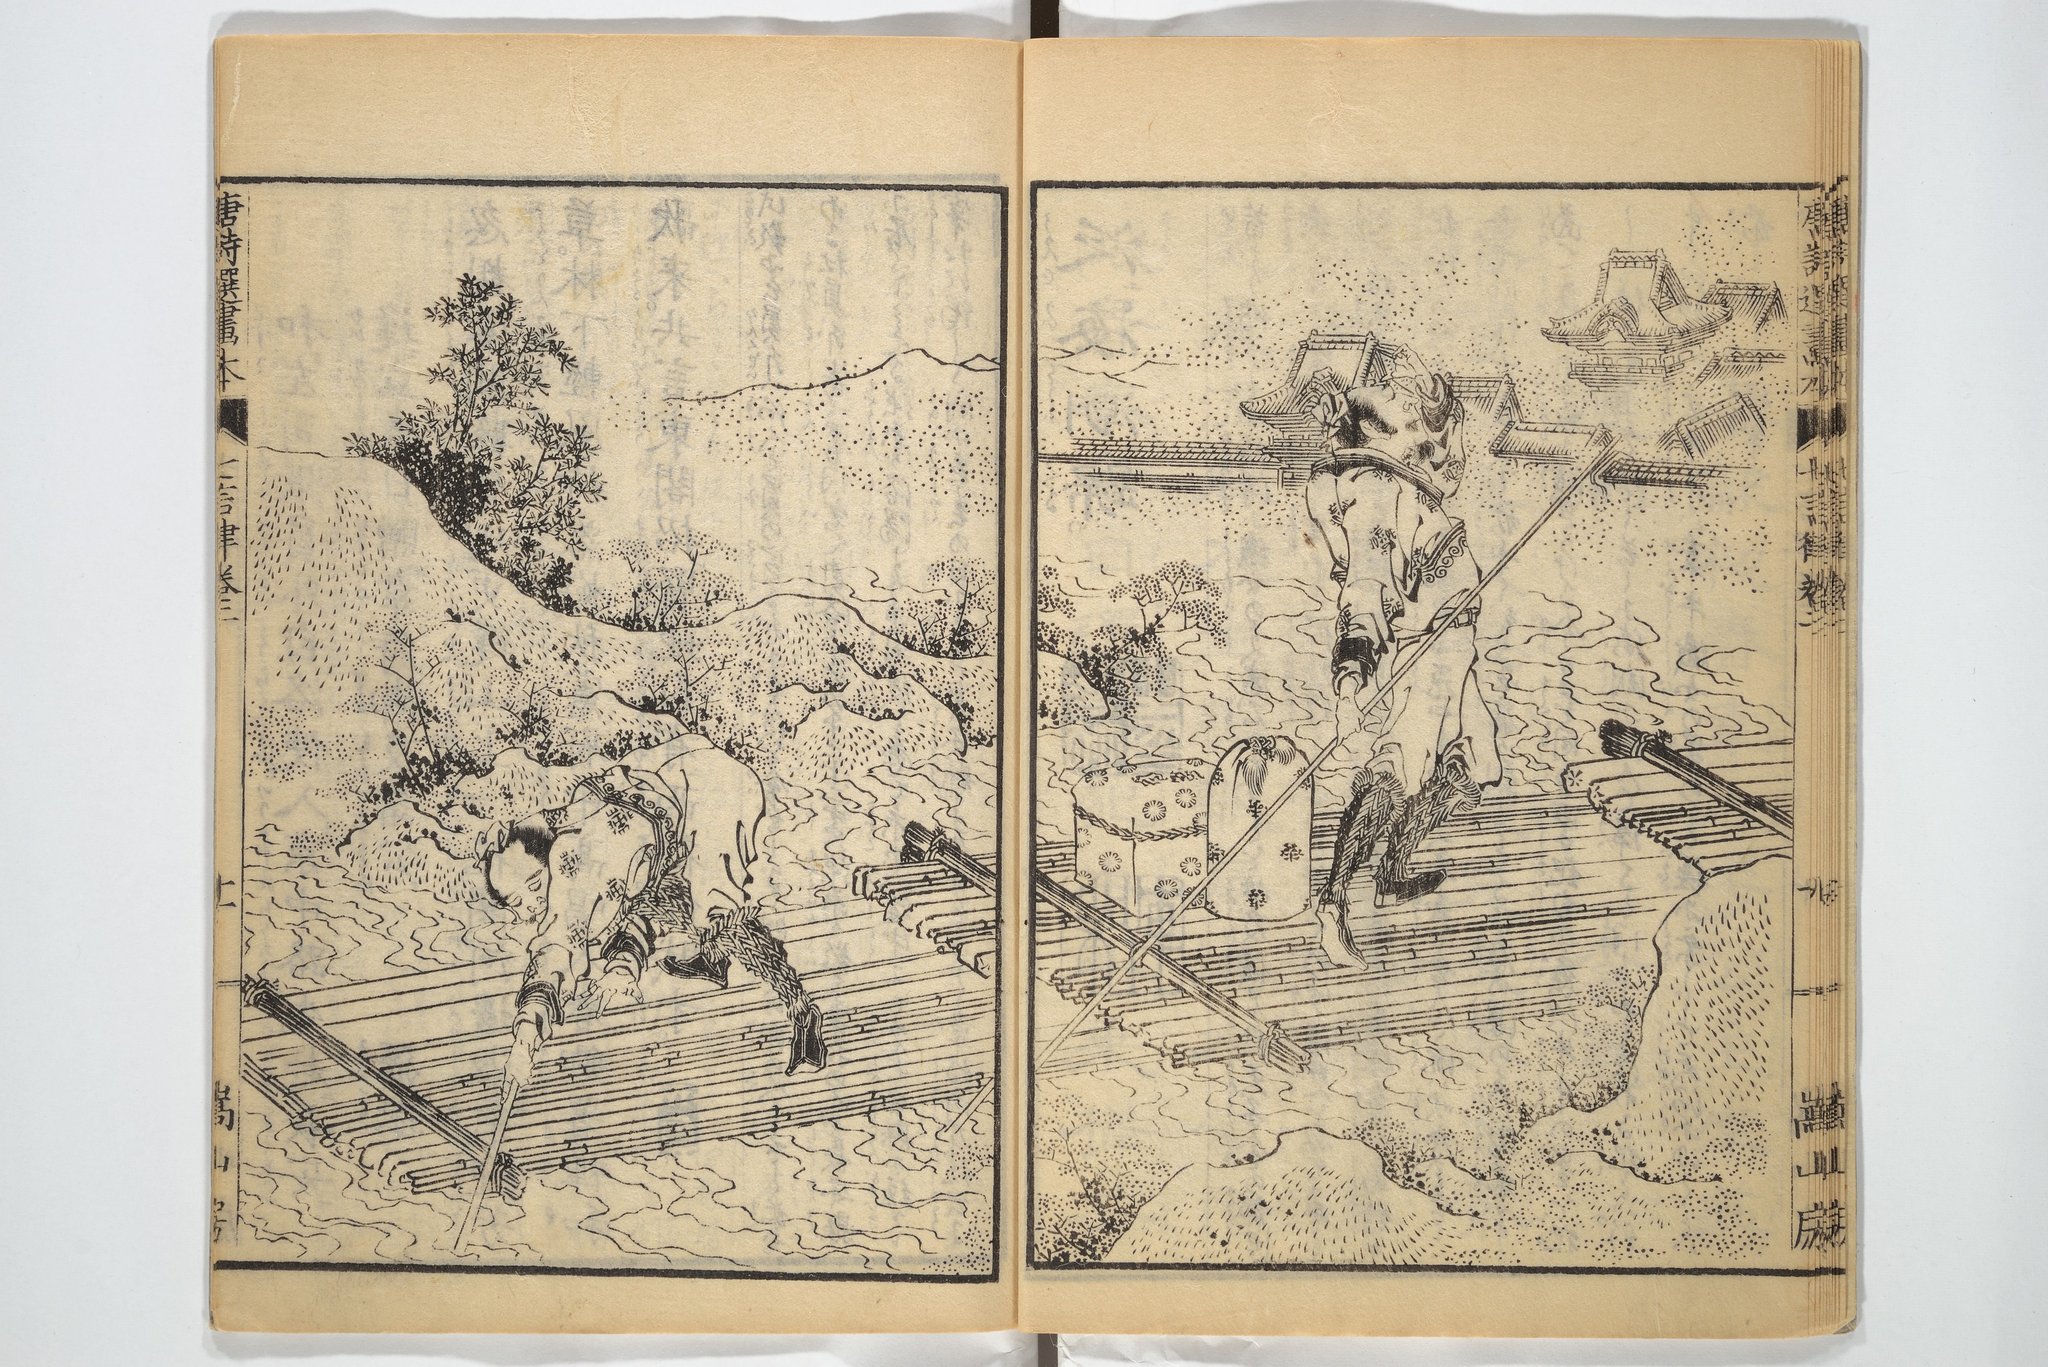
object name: illustrated book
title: Illustrated "Anthology of Tang-Dynasty Poems" in Five-Syllable Lines (Tōshisen ehon gogon ritsu hairitsu) 画本唐詩選五言律排律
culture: japanese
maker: katsushika hokusai 葛飾北斎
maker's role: artist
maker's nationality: japanese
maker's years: 1760-1849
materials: ink, paper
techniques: woodblock print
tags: men